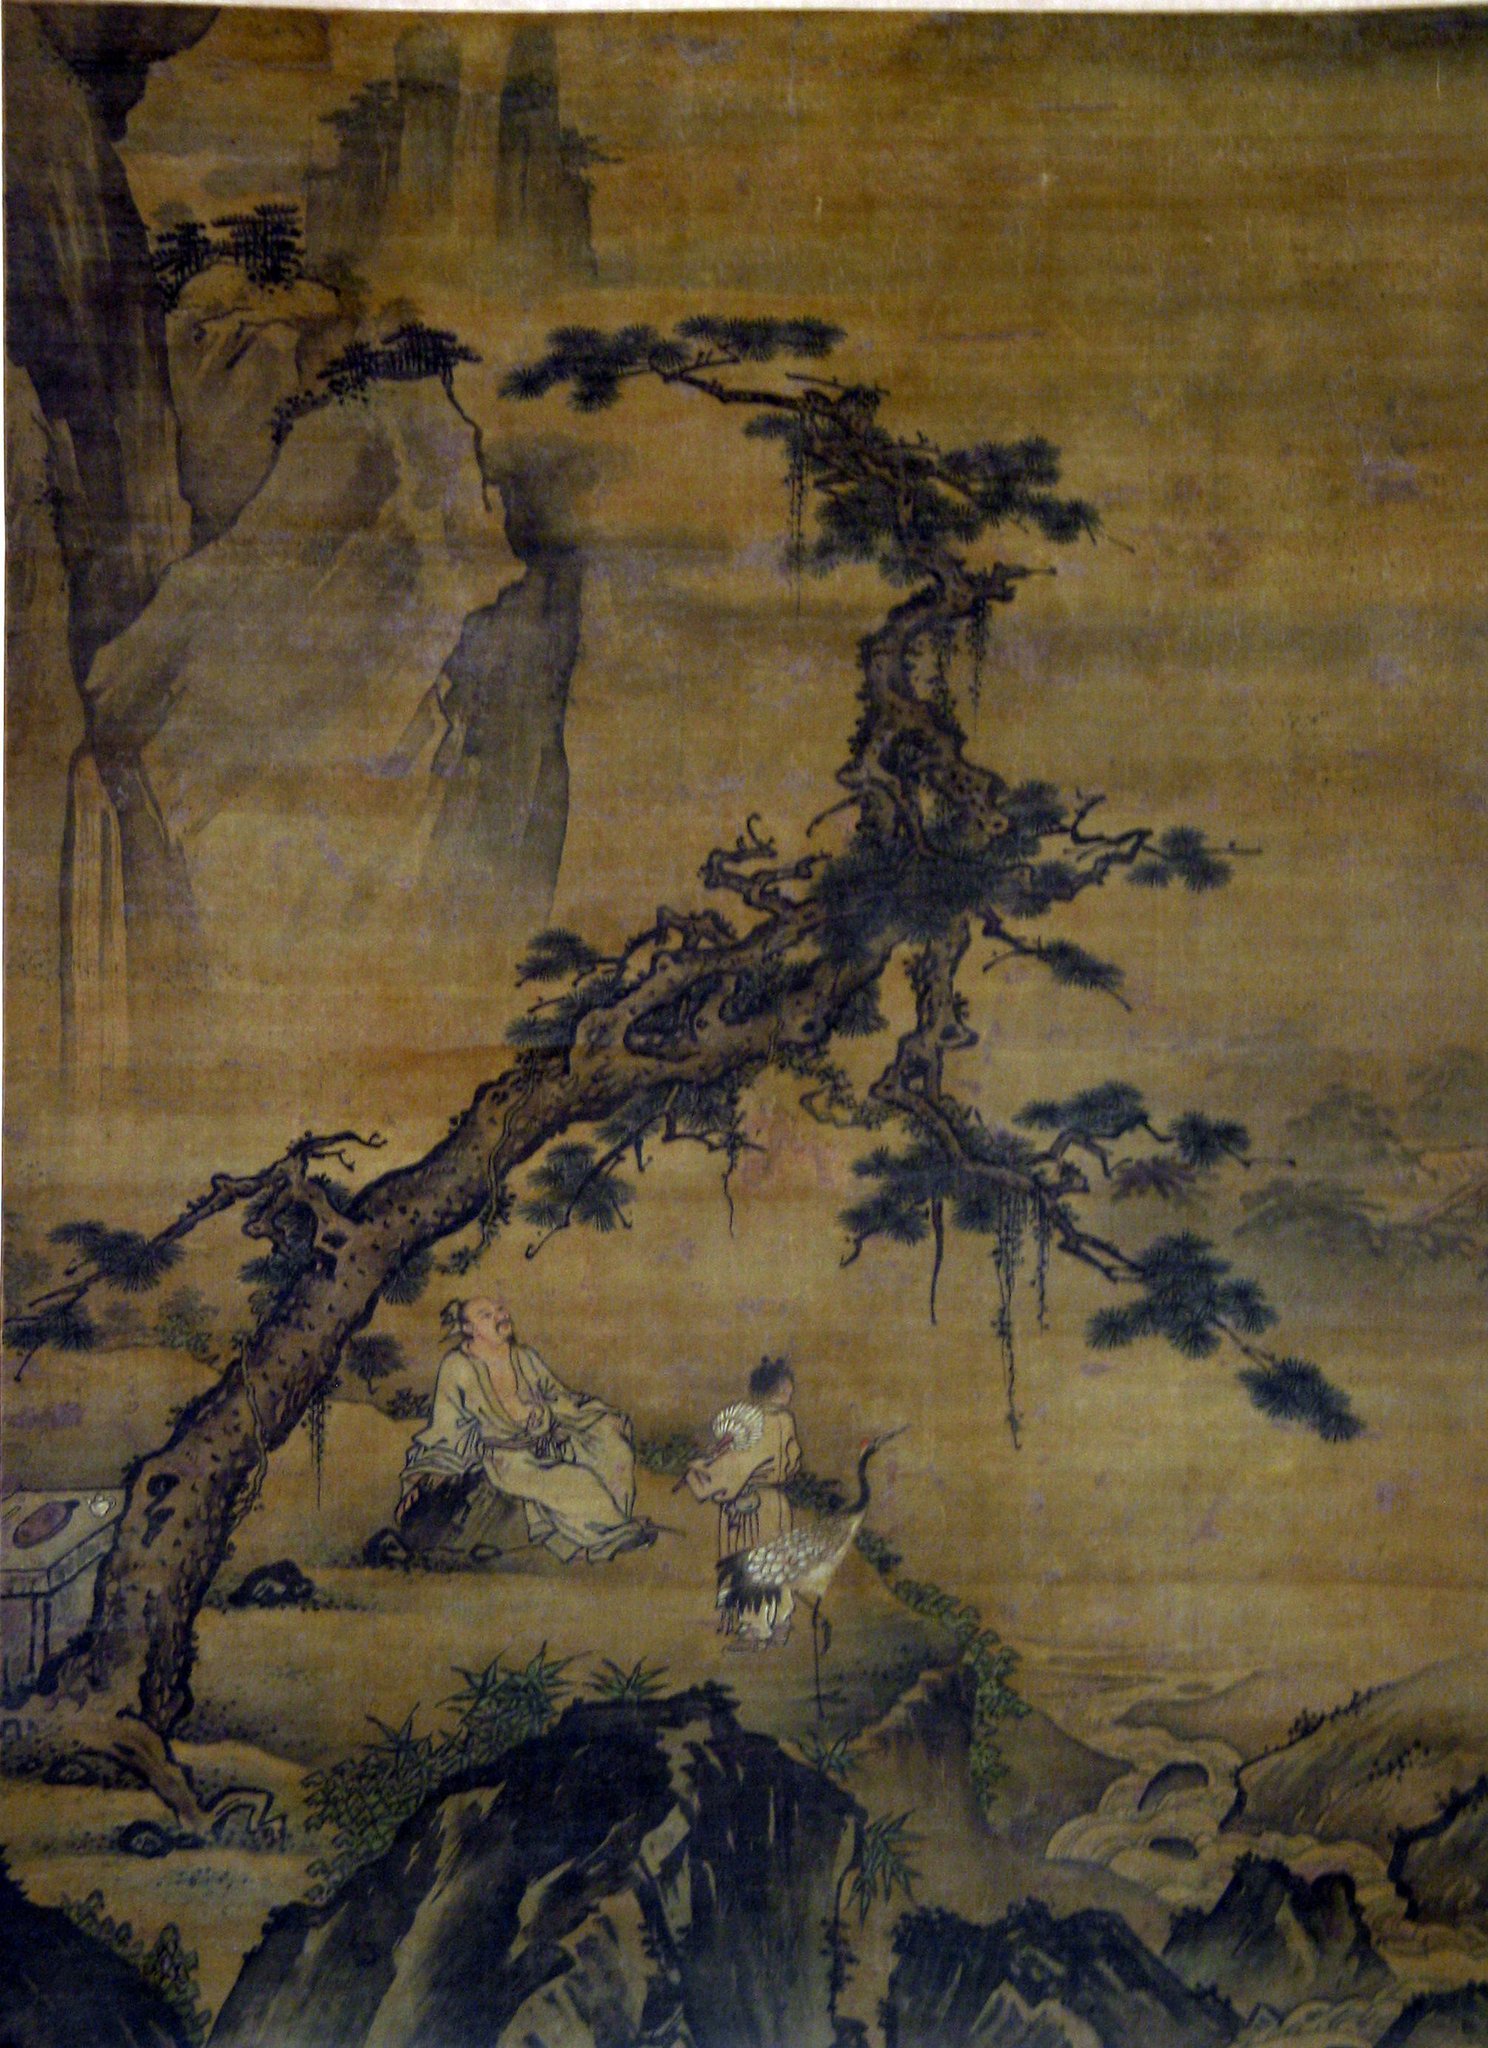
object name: hanging scroll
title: Scholar and Attendant in Mountain Retreat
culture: chinese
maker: unidentified artist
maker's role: artist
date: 1368-1911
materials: ink, silk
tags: cranes,men,mountains,trees